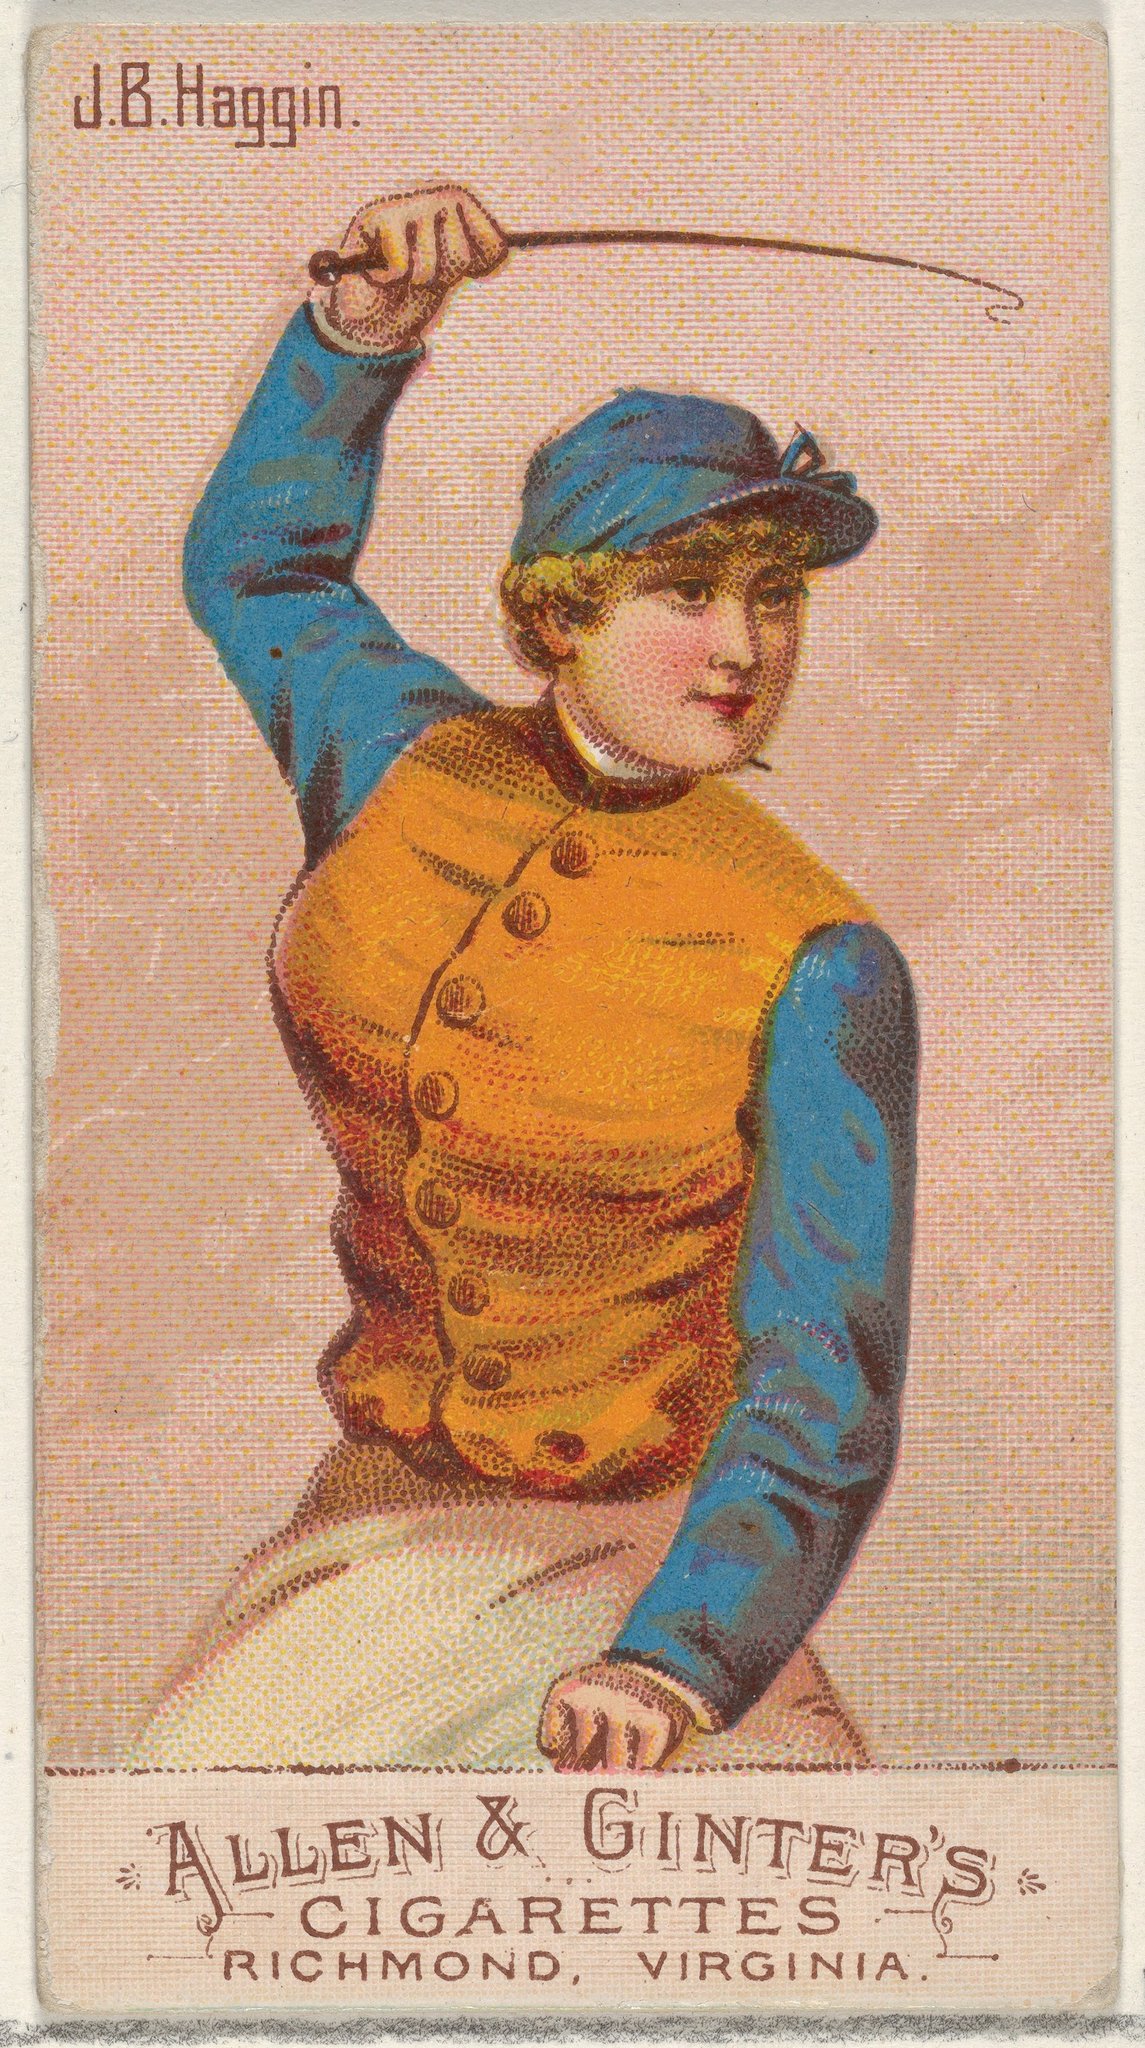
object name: print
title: J.B. Haggin, from the Racing Colors of the World series (N22b) for Allen & Ginter Cigarettes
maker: allen & ginter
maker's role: publisher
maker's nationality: american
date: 1888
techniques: color lithograph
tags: women,jockeys